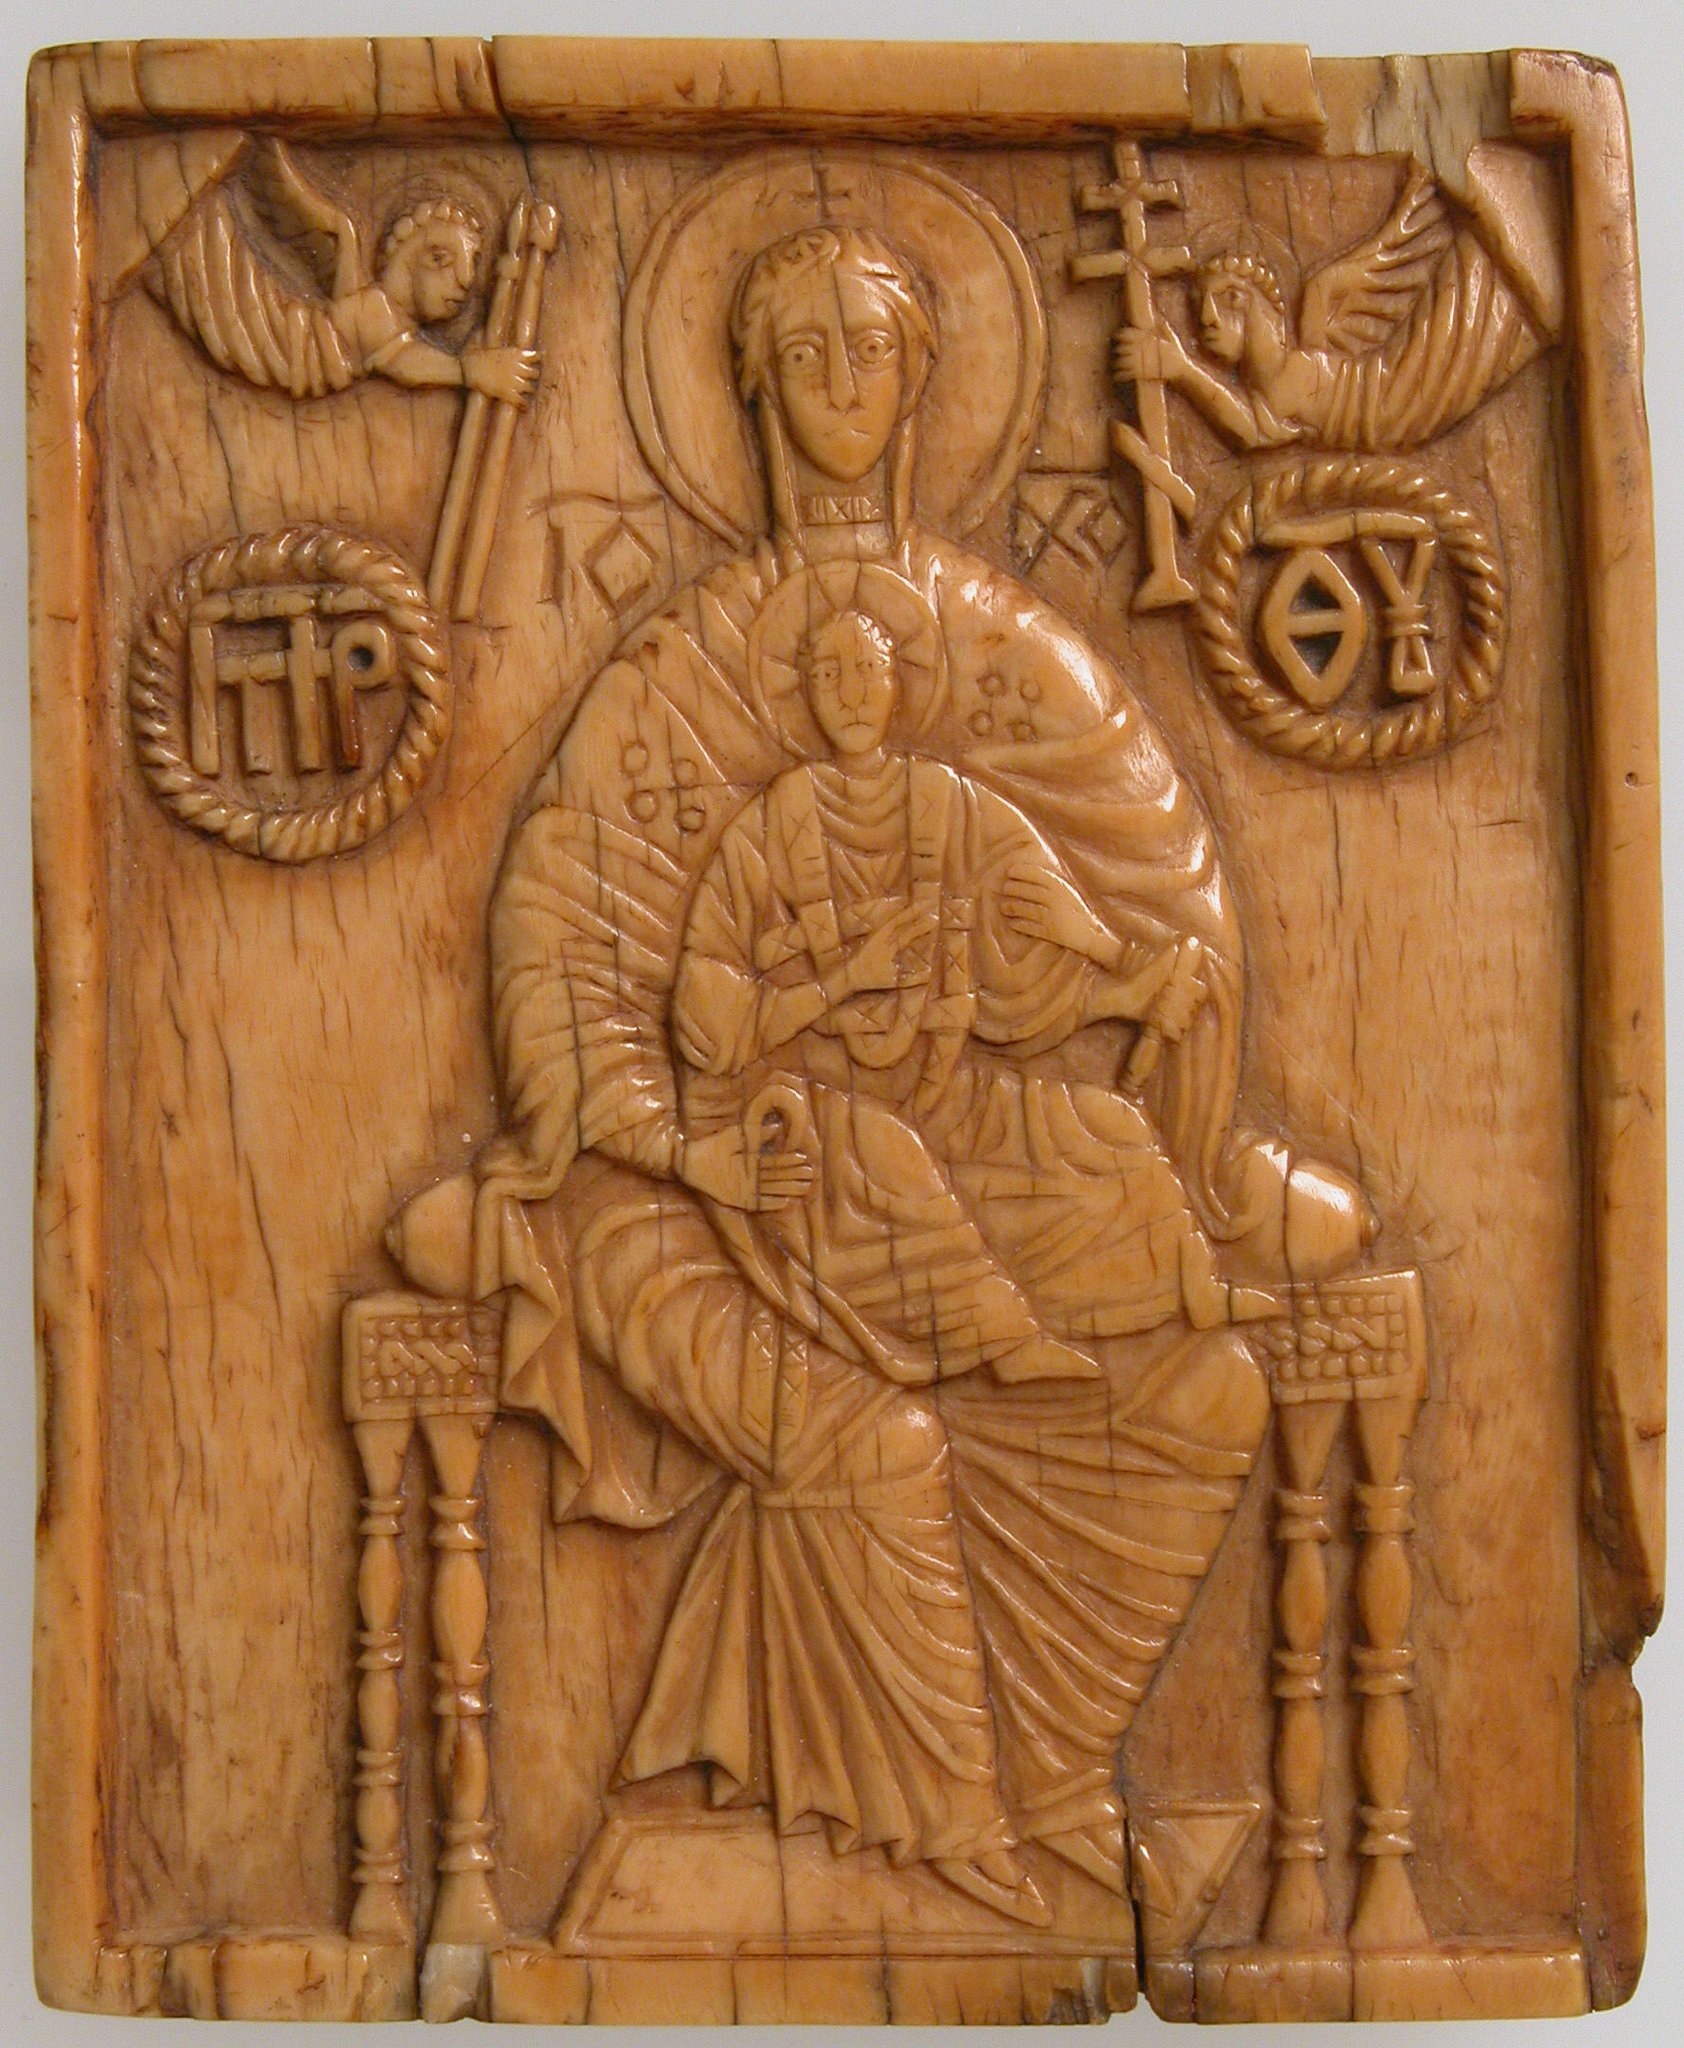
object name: plaque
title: Icon with Virgin and the Christ Child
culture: greek or russian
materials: ivory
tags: angels,madonna and child